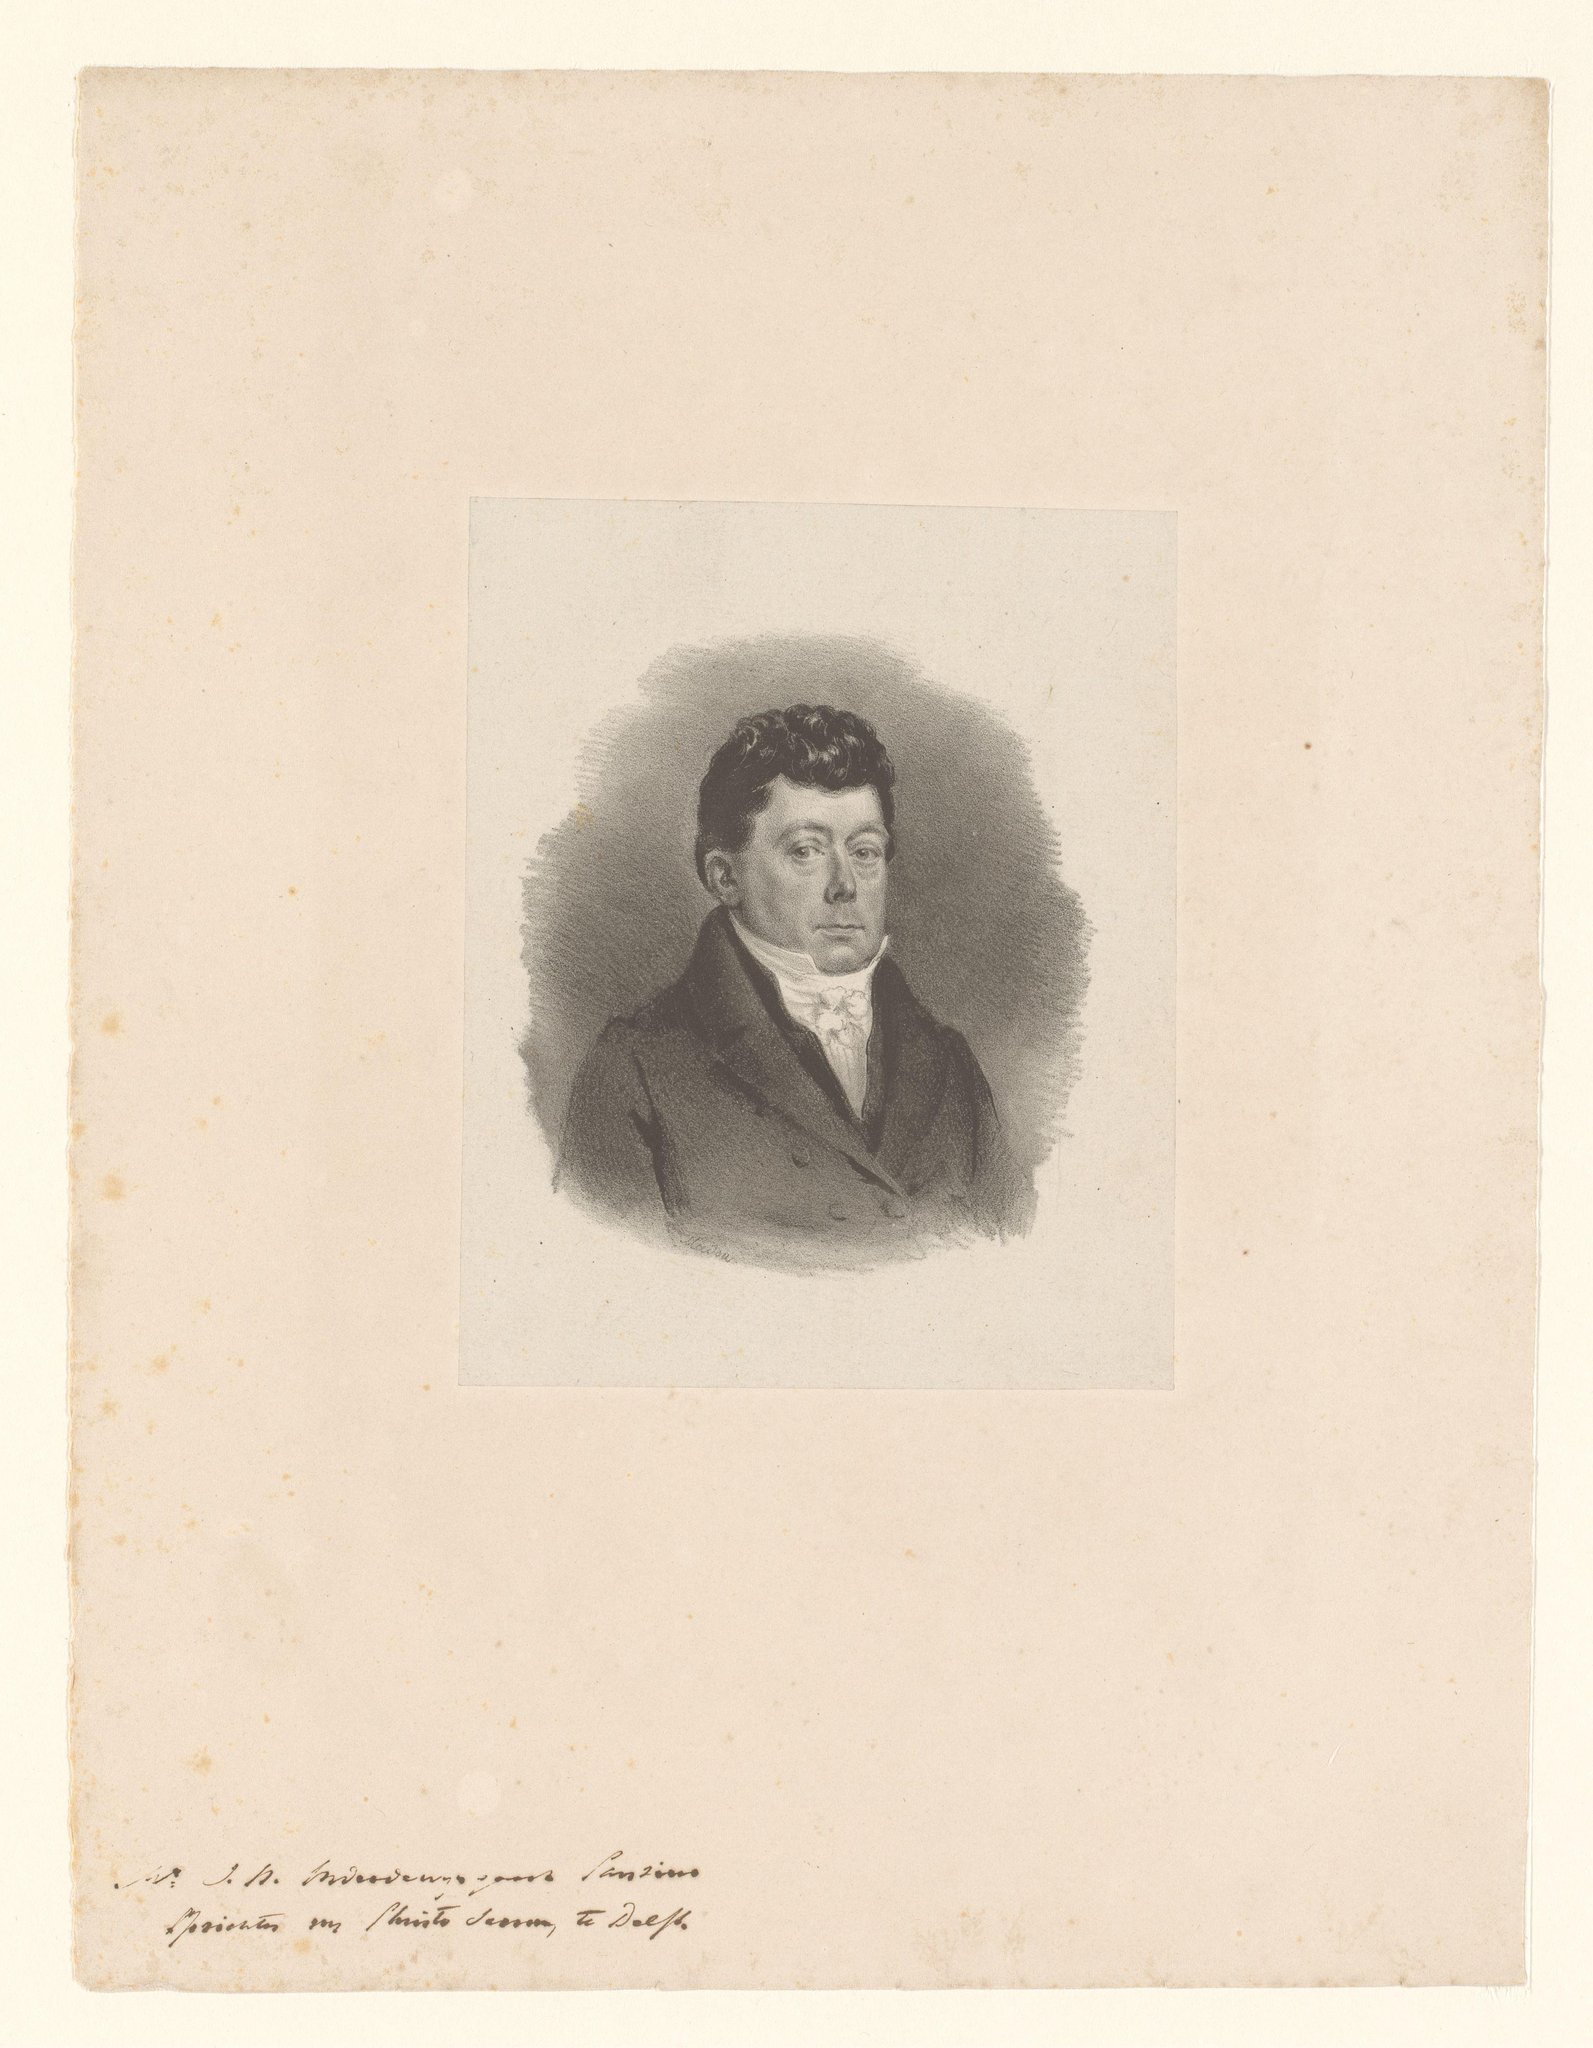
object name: print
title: Portret van Jacob Hendrik Onderdewijngaart Canzius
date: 1806-1877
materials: paper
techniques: lithograph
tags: delft, jacob hendrik onderdewijngaart canzius, adult man, historical persons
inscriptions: inscription: ‘j.h. Onderdewijngaart Canzius, opzichter van Christo sacrum, te Delft’